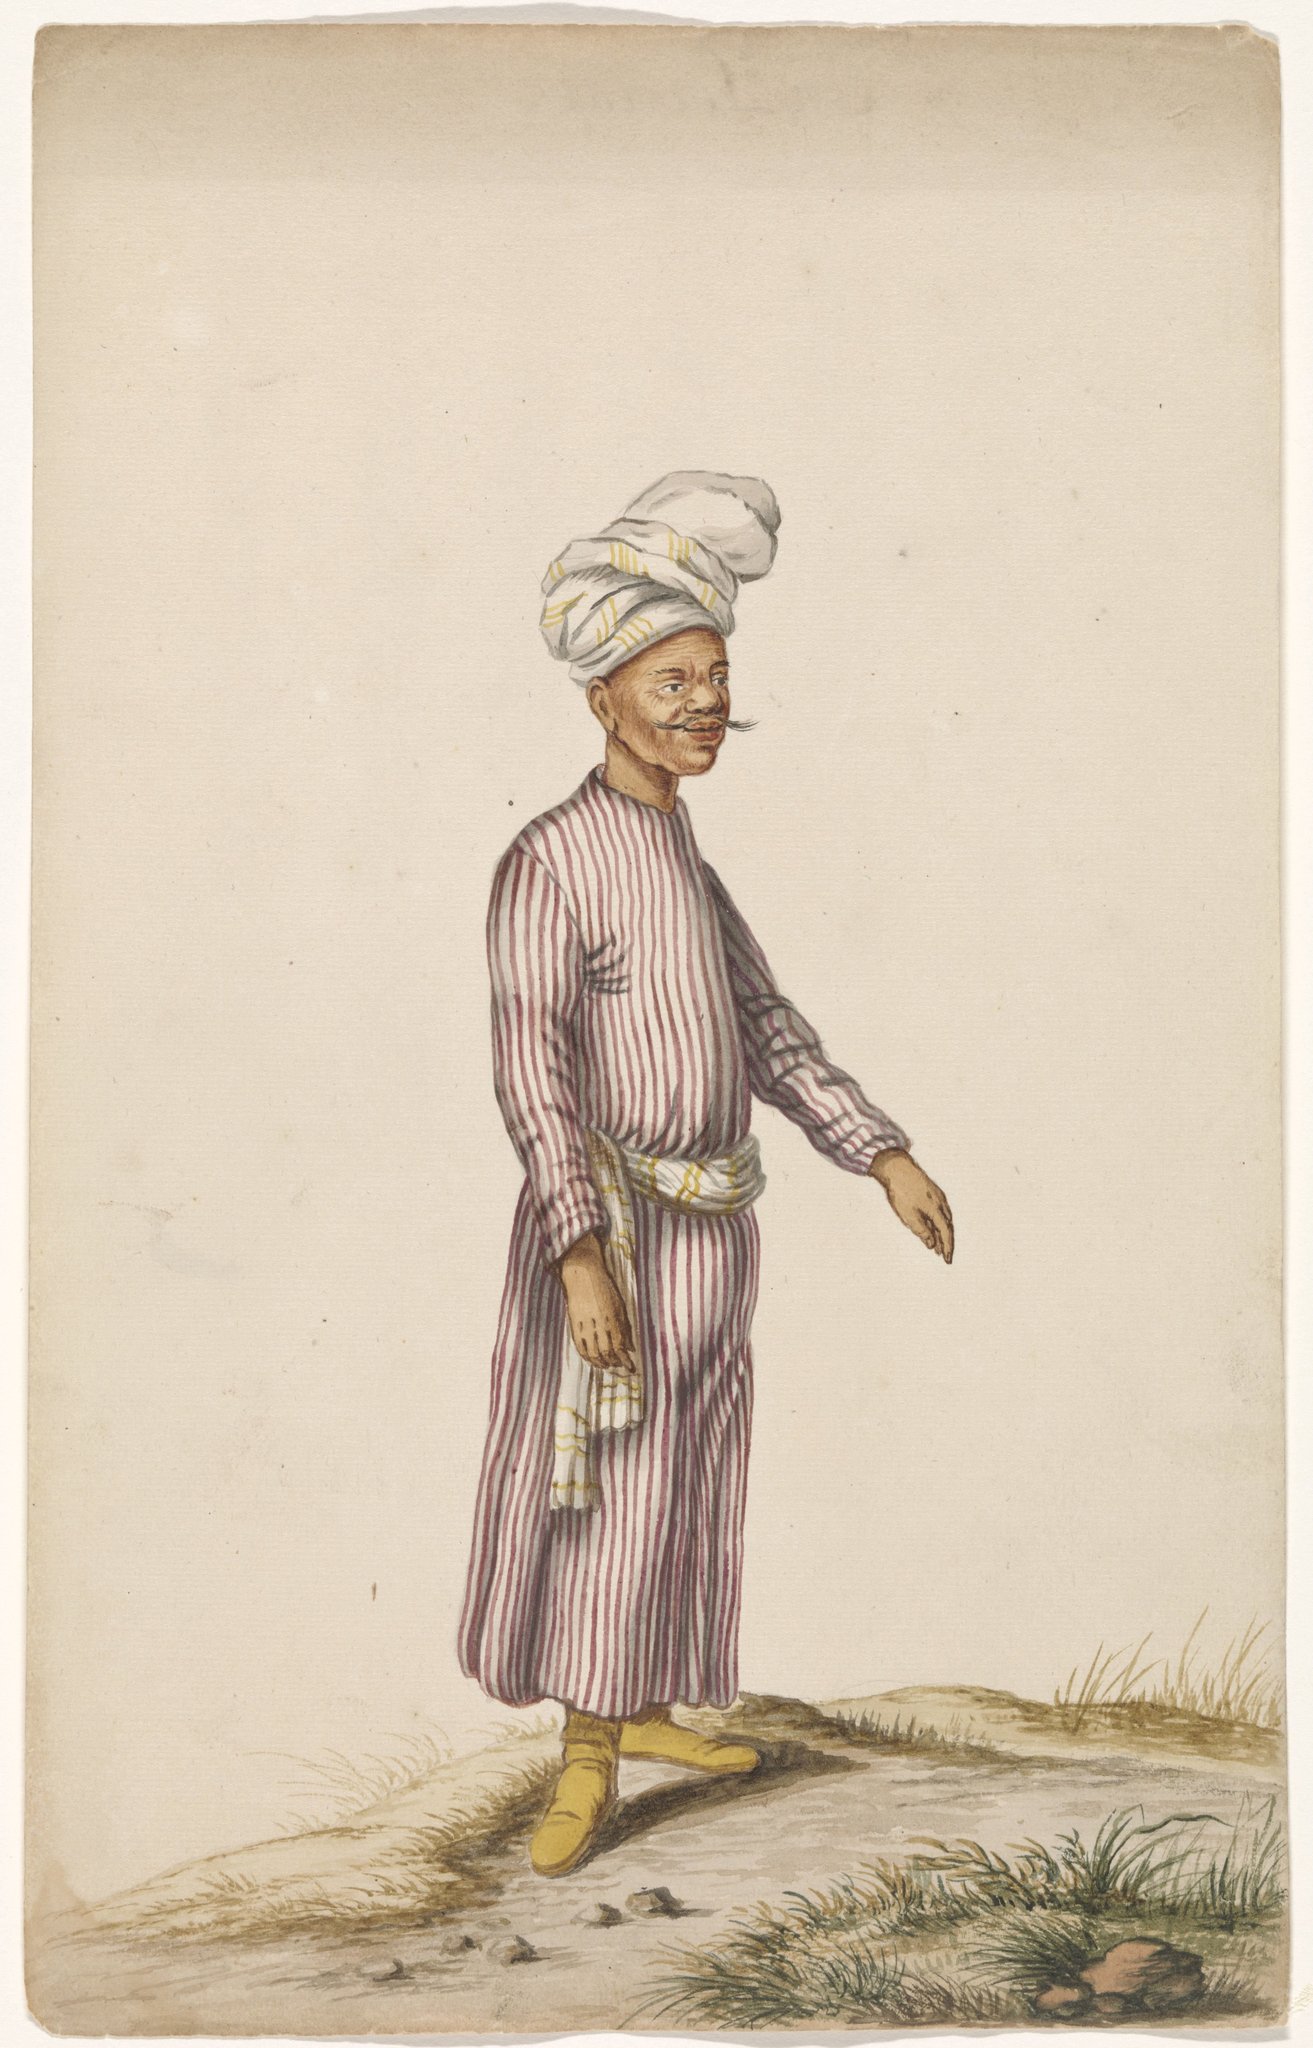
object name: drawing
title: A Persian Man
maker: Anonymous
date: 1675-1725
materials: paper, watercolor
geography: netherlands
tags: asiatic races and peoples, persia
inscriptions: annotation: ‘Een Persiaen’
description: Een Pers omet leren laarzen, een paars-wit gestreepte kaftan, met een geel/witte sjaal om zijn middel. Op zijn hoofd draagt hij een wit/gele tulband.